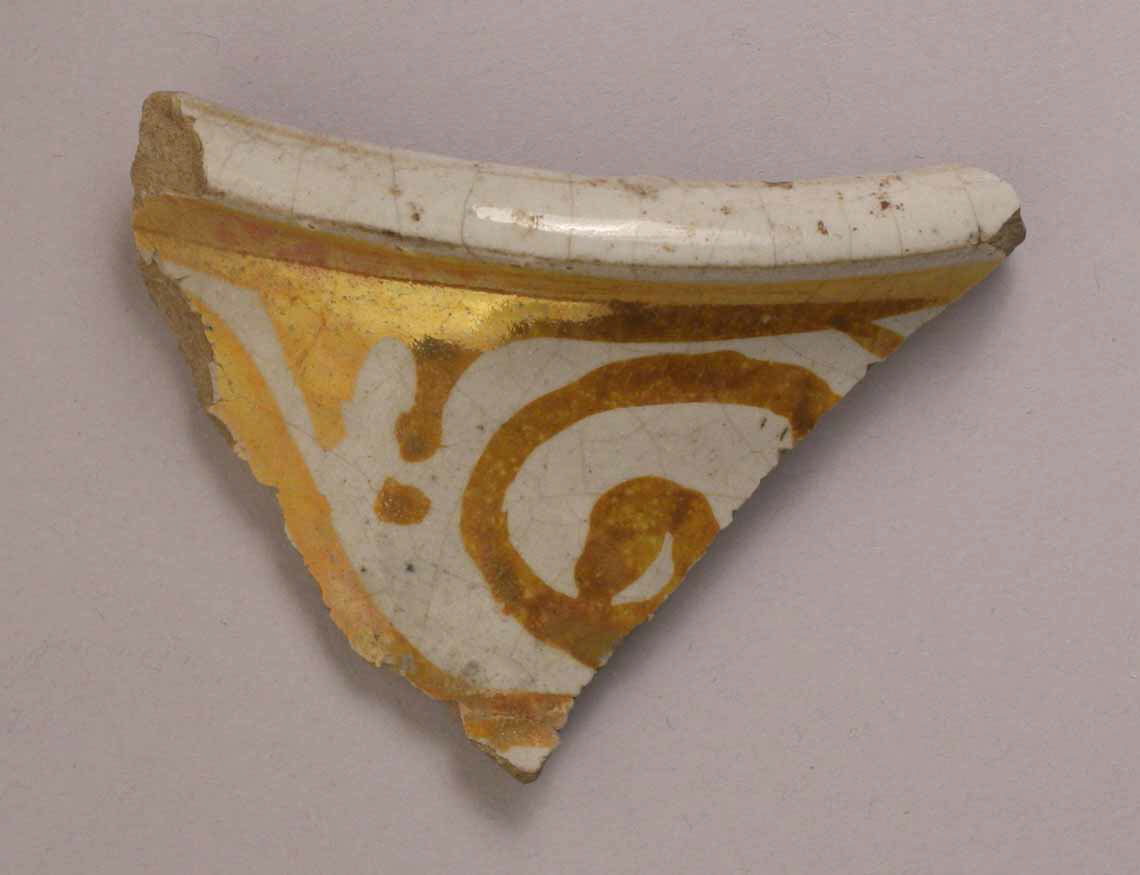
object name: ceramic fragment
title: Fragment of a Dish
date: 901-1100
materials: earthenware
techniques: luster painting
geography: egypt